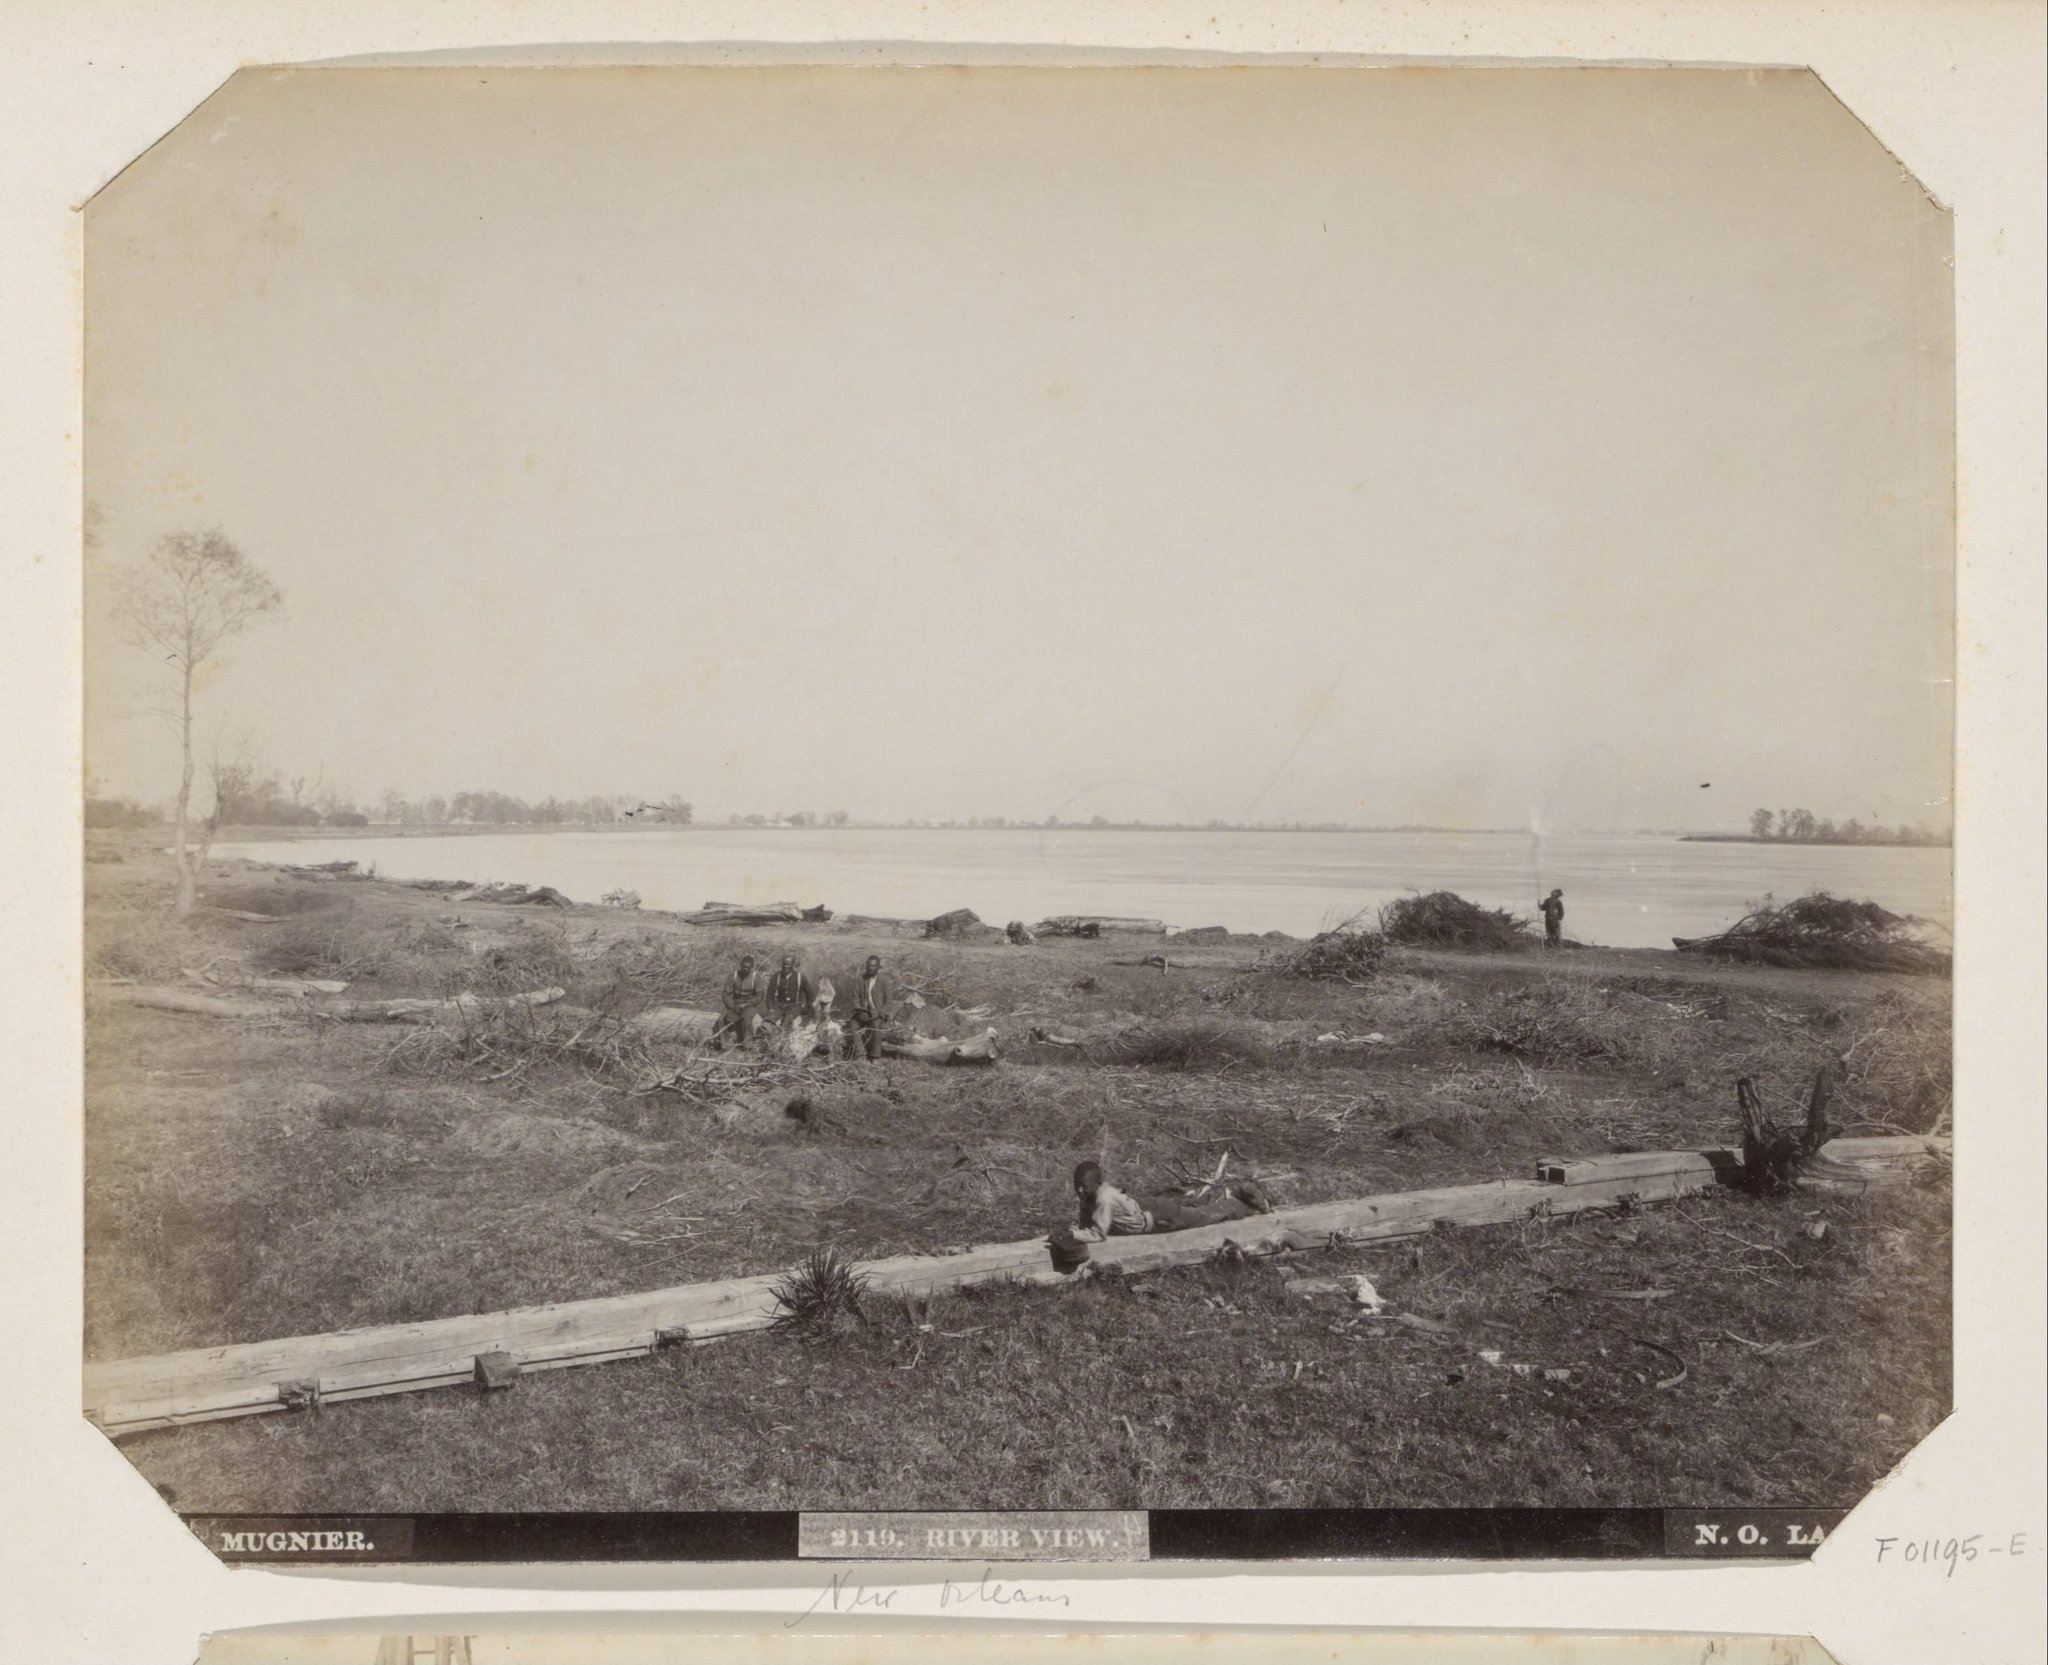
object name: photograph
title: Mensen aan de oever van een rivier in New Orleans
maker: george françois mugnier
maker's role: fotograaf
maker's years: 1855-1938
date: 1880-1888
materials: cardboard, paper, photographic support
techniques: albumen print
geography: new orleans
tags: new orleans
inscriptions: negative number: ‘2119’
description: Onderdeel van Fotoalbum van een reis door de Verenigde Staten, Honolulu, Nederlands-Indië, Aden, Zanzibar en Zuidelijk Afrika.